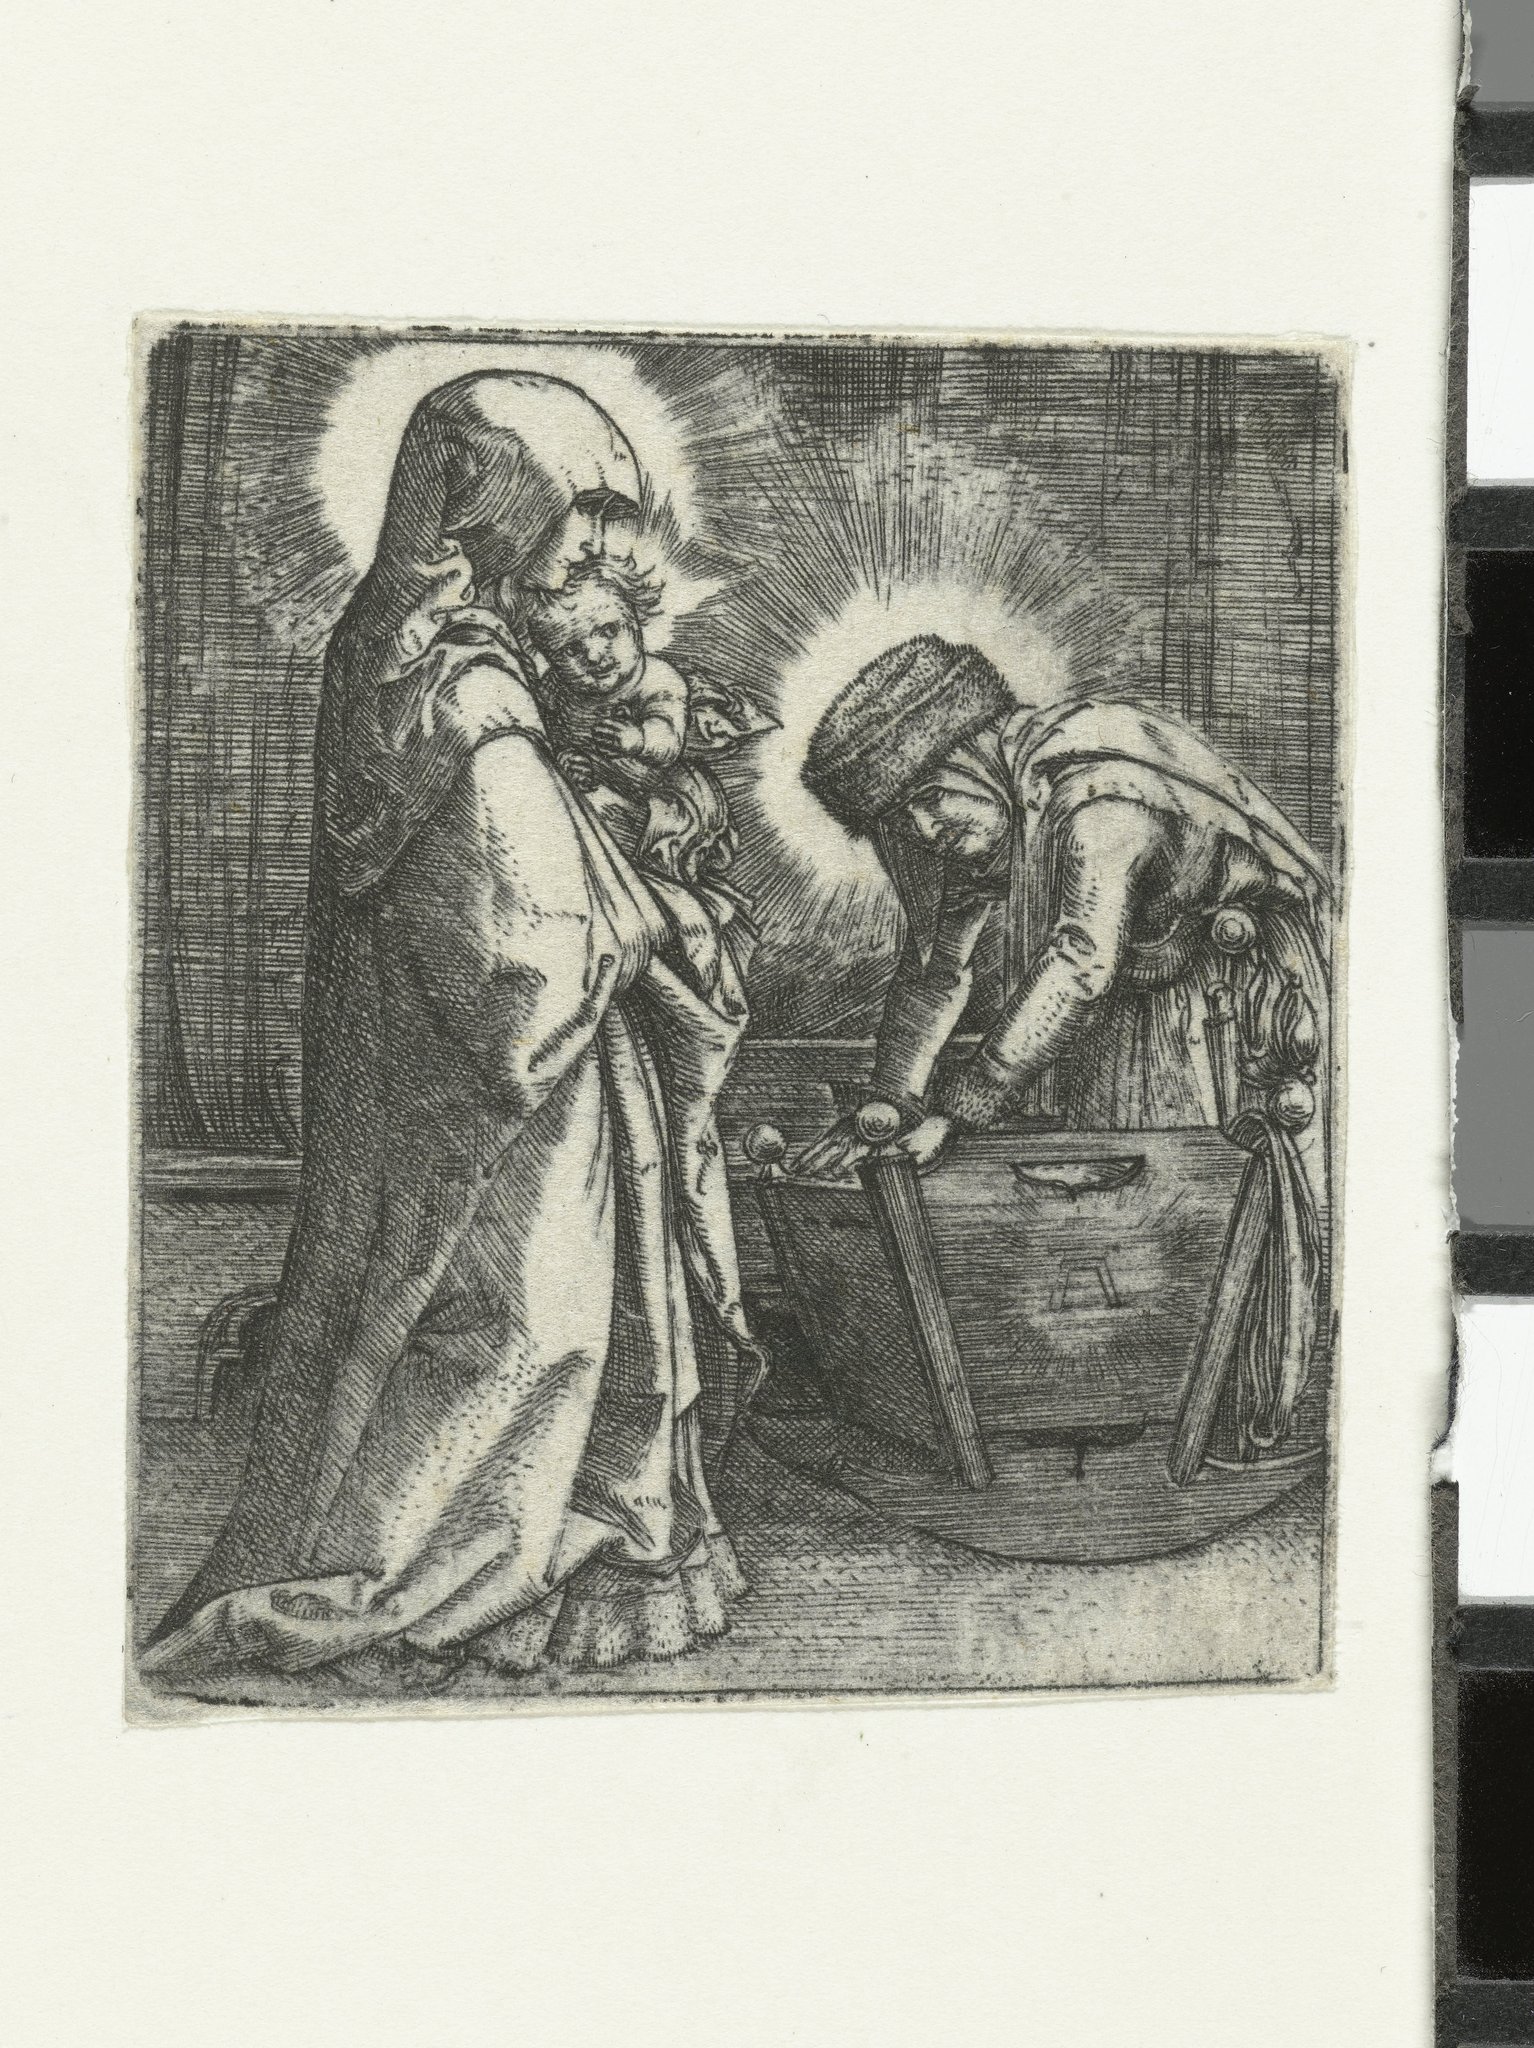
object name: print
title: Maria met het Christuskind en Anna bij een wieg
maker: albrecht altdorfer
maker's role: draughtsman, print maker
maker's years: 1480-1538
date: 1506-1538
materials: paper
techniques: engraving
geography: germany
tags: 'anna selbdritt', i.e. anna, mary and christ-child close together, cradle, crib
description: Maria met het Christuskind op de arm. De heilige Anna voorovergebogen over de wieg.